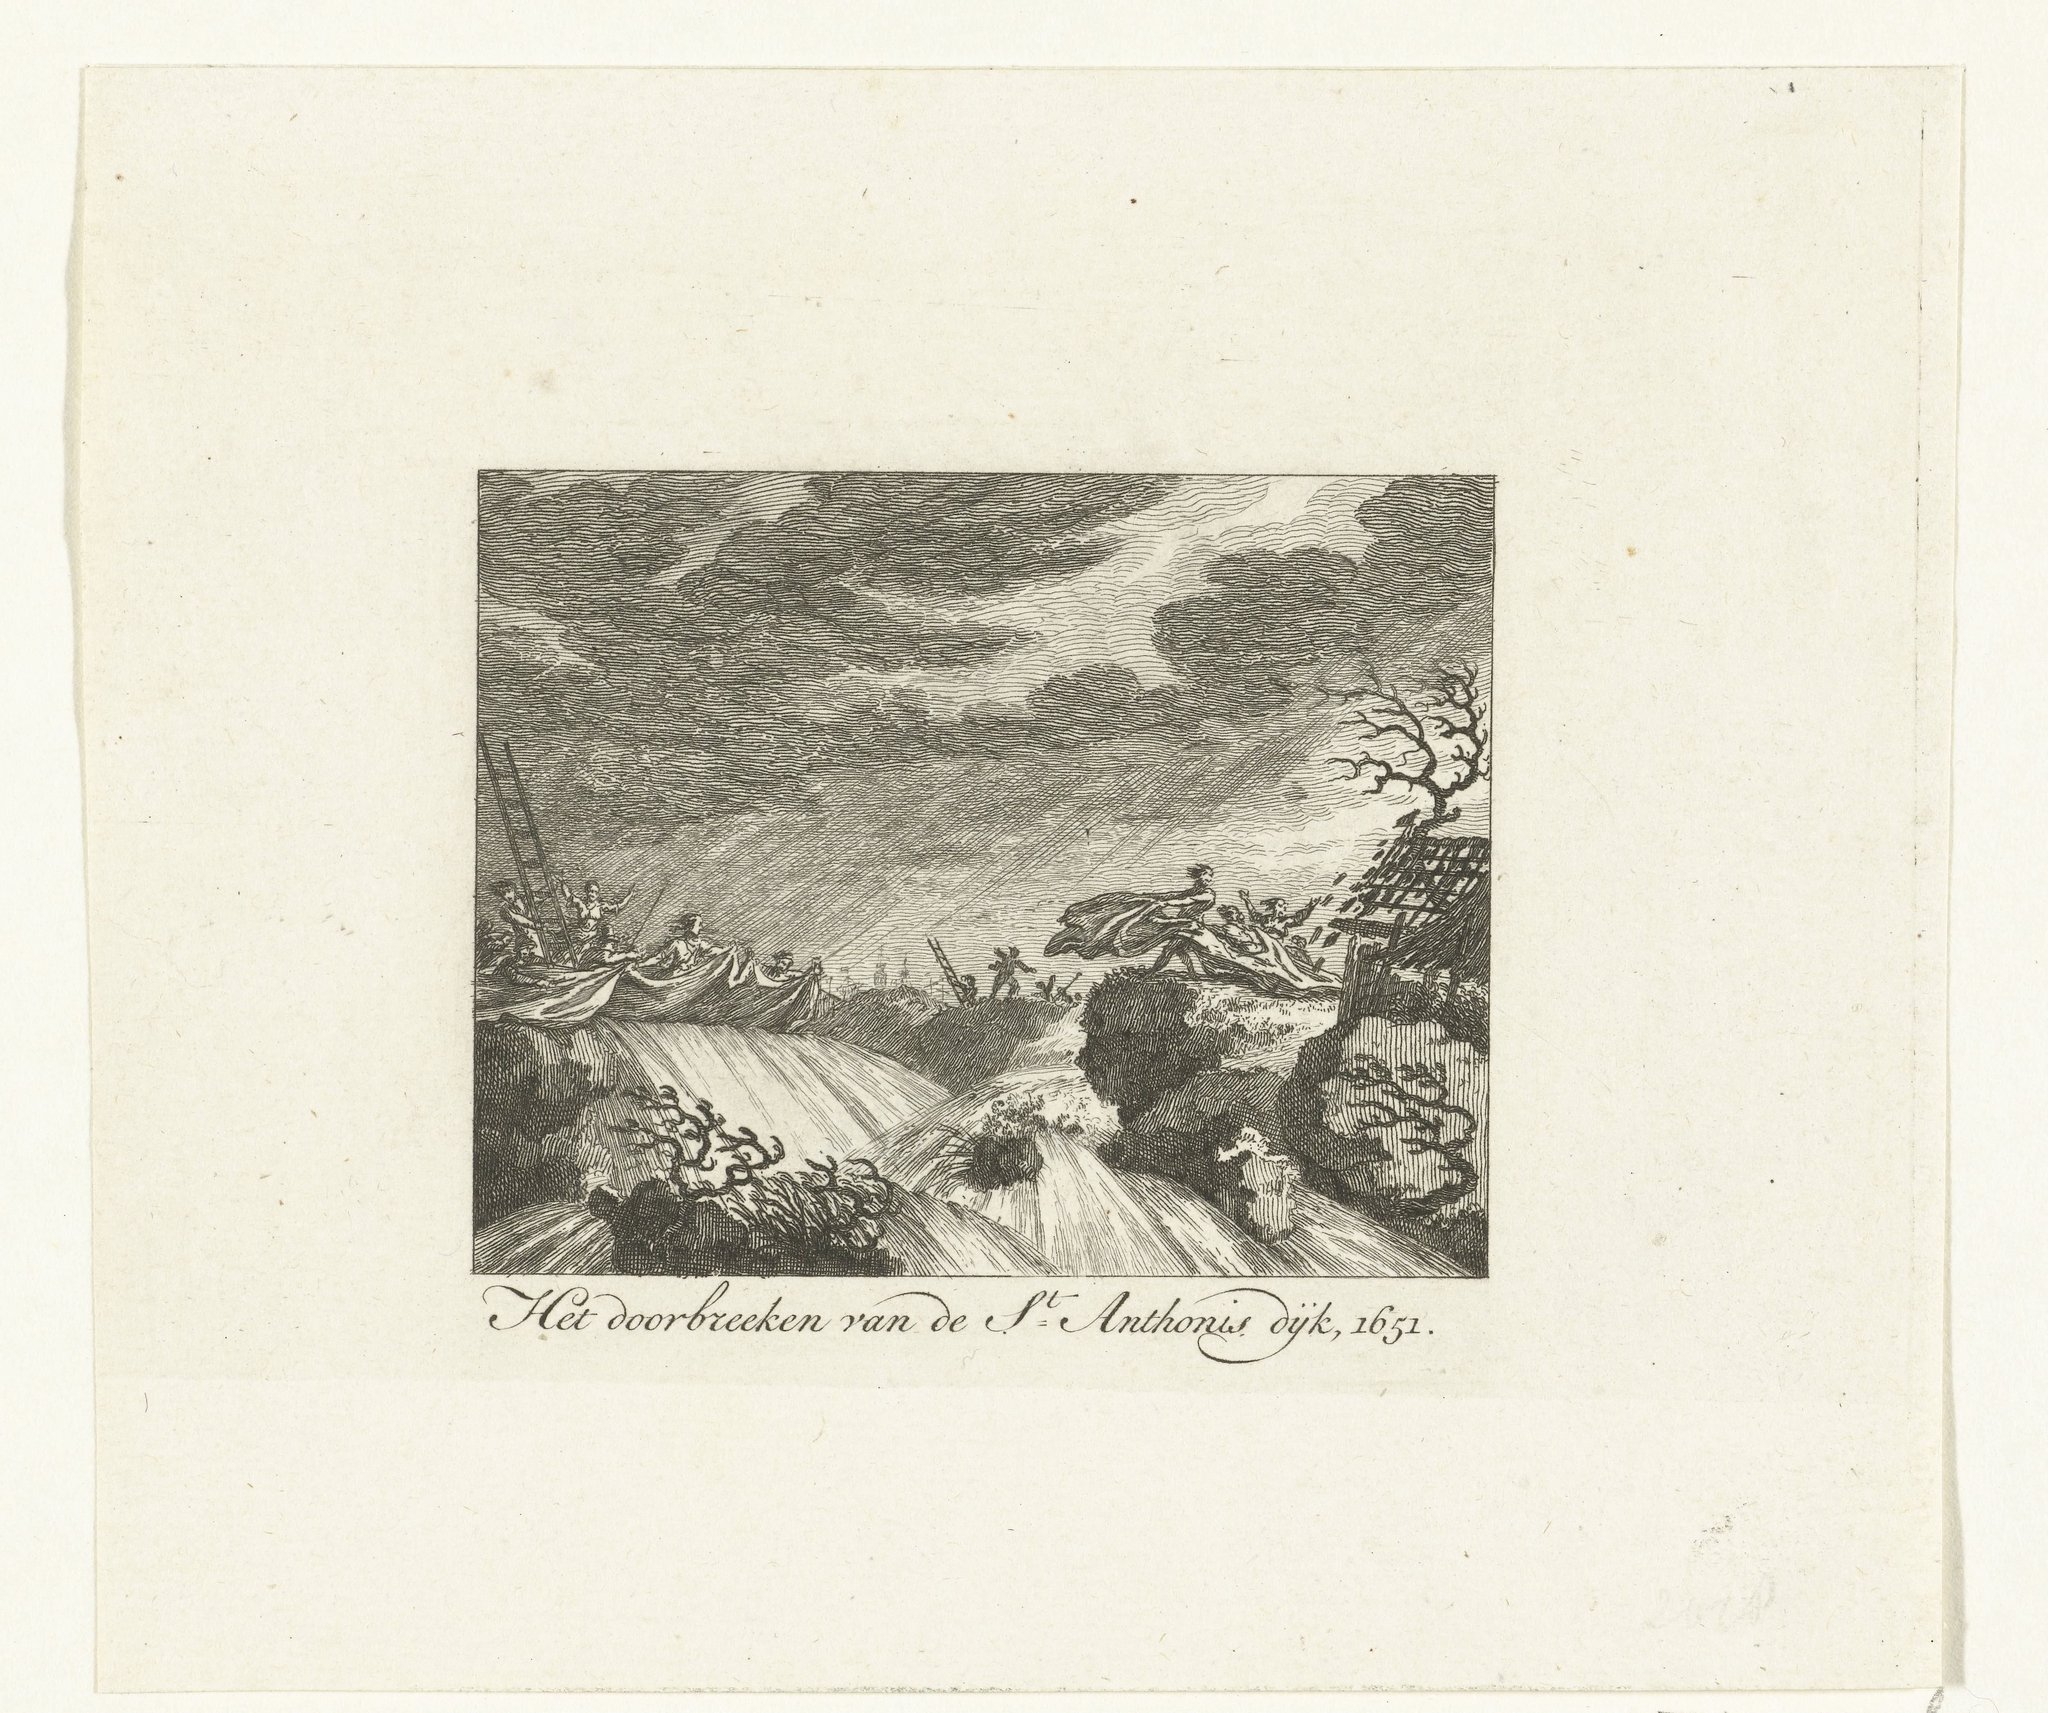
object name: history print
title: Het doorbreken van de St. Anthonis dijk, 1651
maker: simon fokke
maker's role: draughtsman, print maker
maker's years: 1712-1784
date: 1780-1782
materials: paper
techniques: etching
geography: northern netherlands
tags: dike-break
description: Dijkdoorbraak van de Sint-Antoniesdijk of Diemerzeedijk bij Houtewael buiten Amsterdam op 5 maart 1651, veroorzaakt door de hoge watervloed en de sterke noordwester storm. Het water stroomt door het gat in de dijk, aan weerszijden van het gat toeschouwers in paniek.